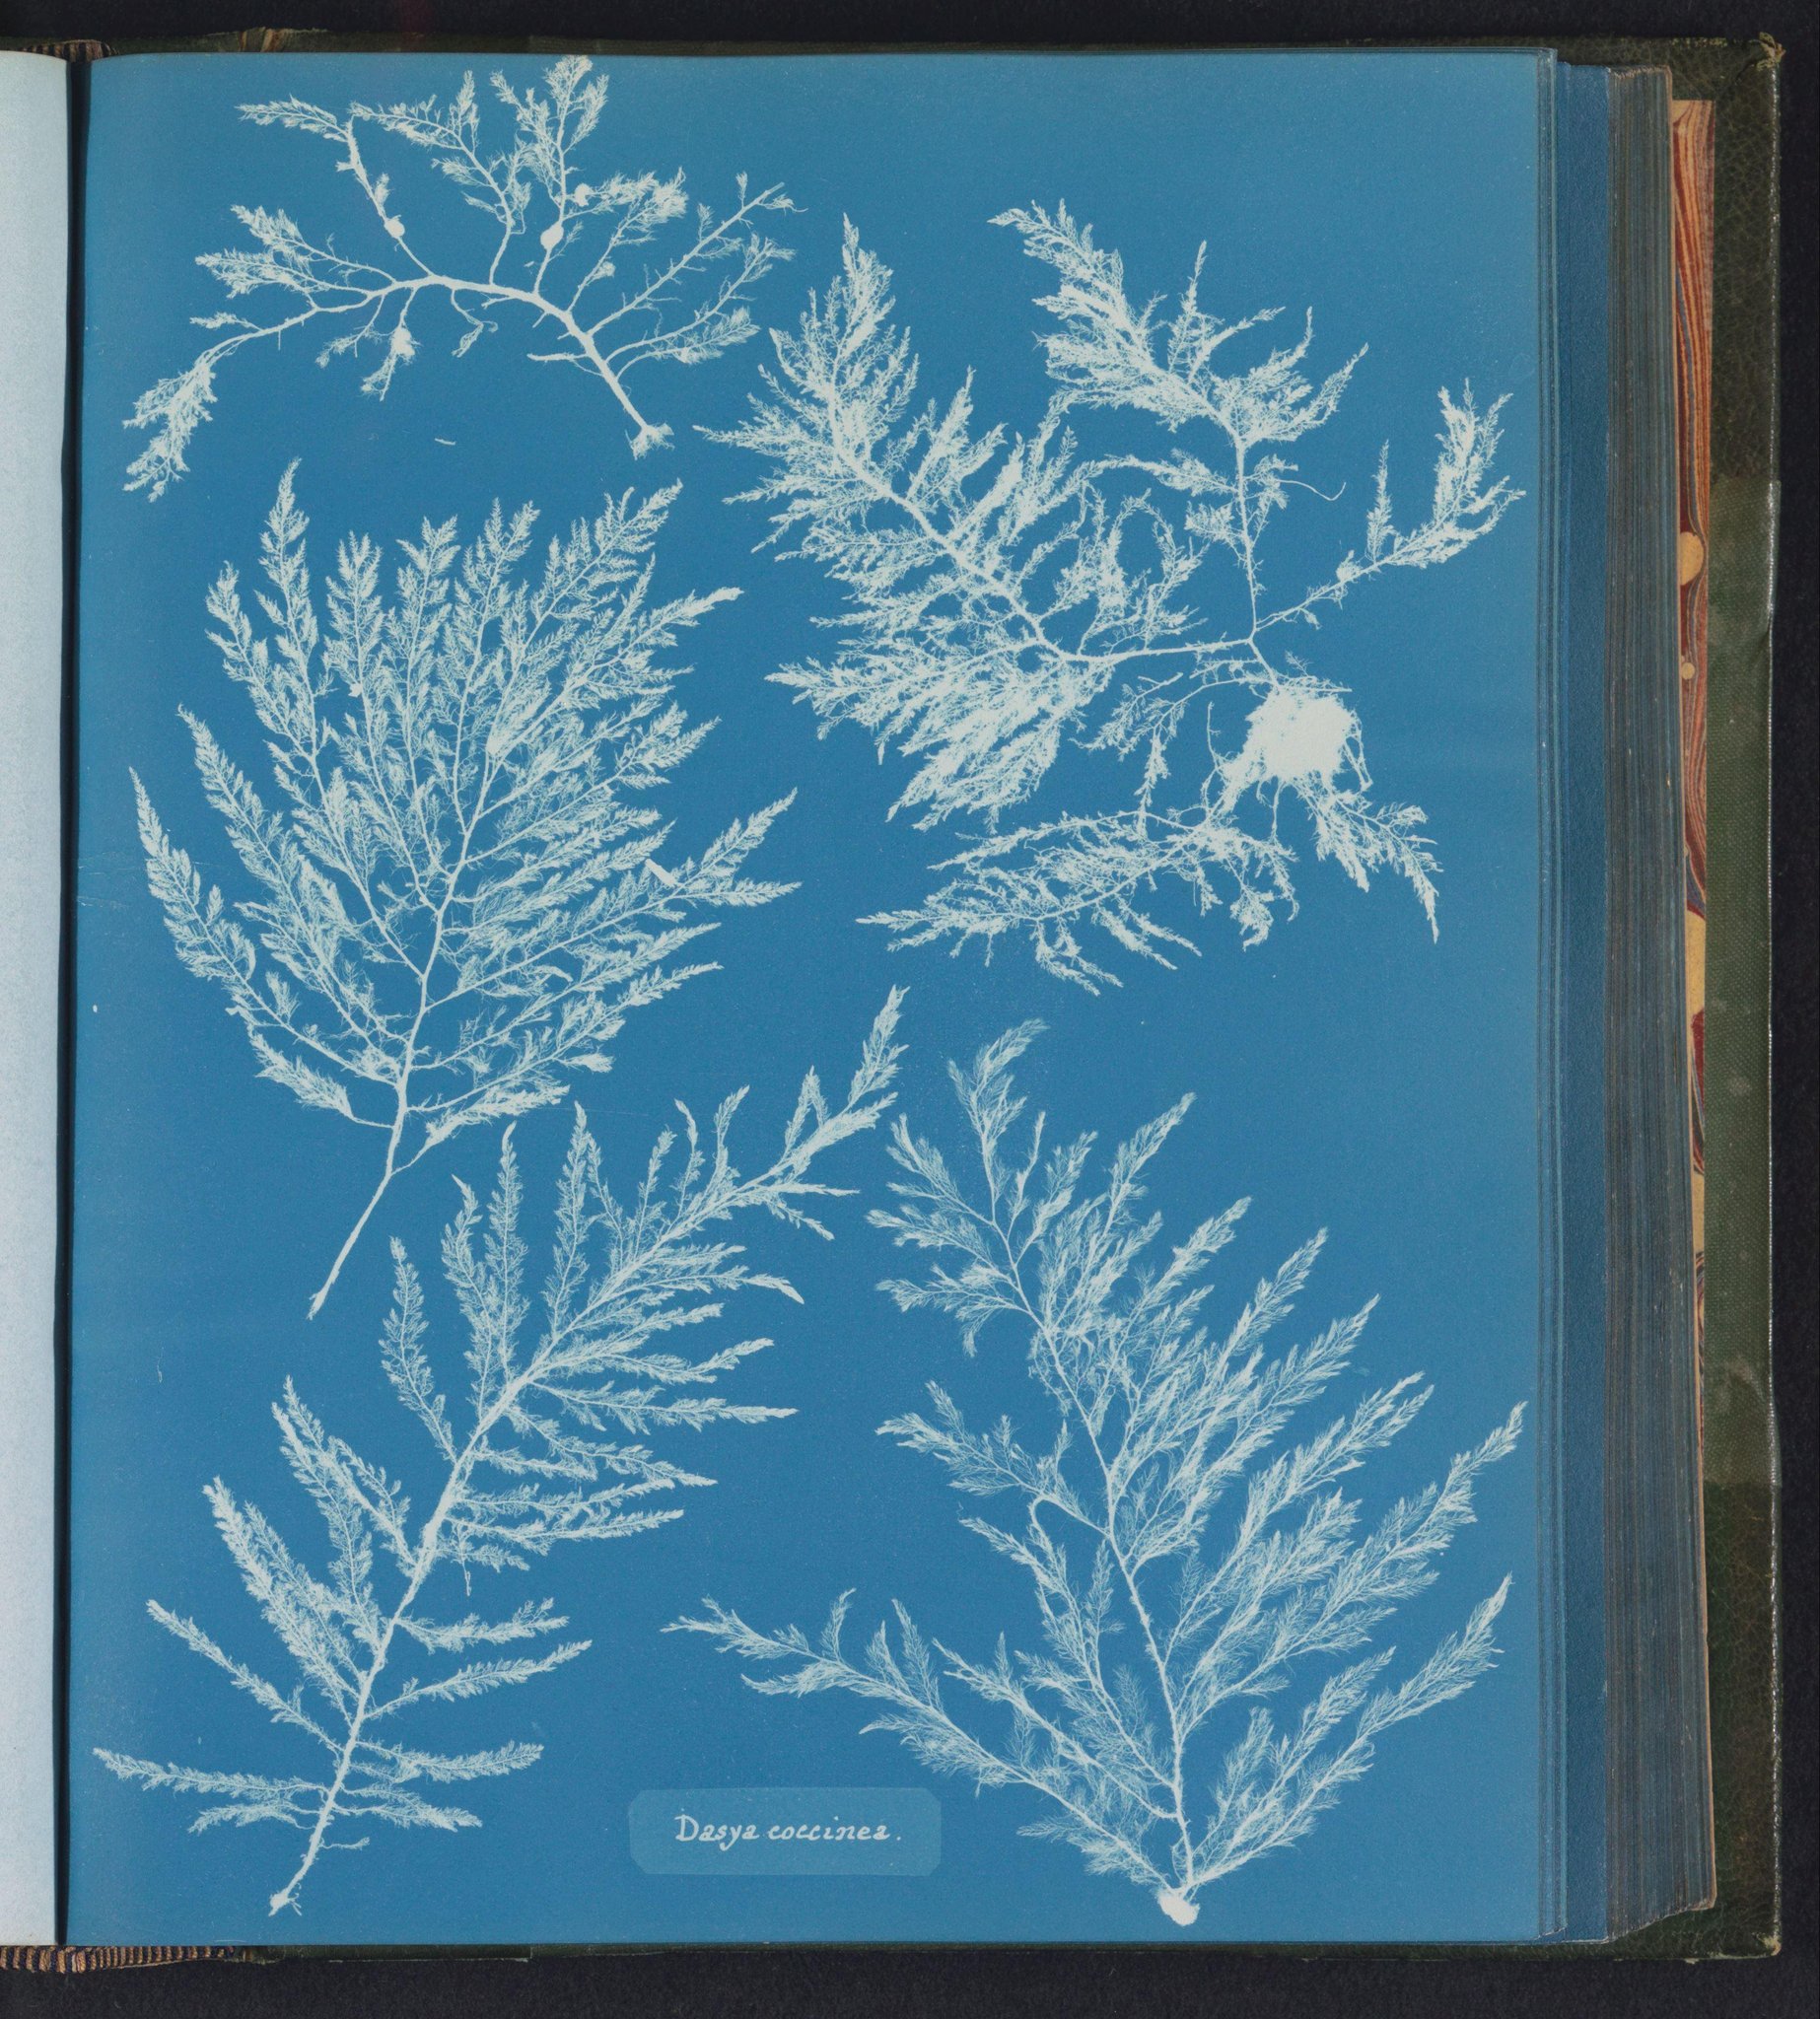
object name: page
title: Zeewier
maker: anna atkins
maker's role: fotograaf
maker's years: 1799-1871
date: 1843-1853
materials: photographic support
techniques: cyanotype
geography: united kingdom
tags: algae, seaweed